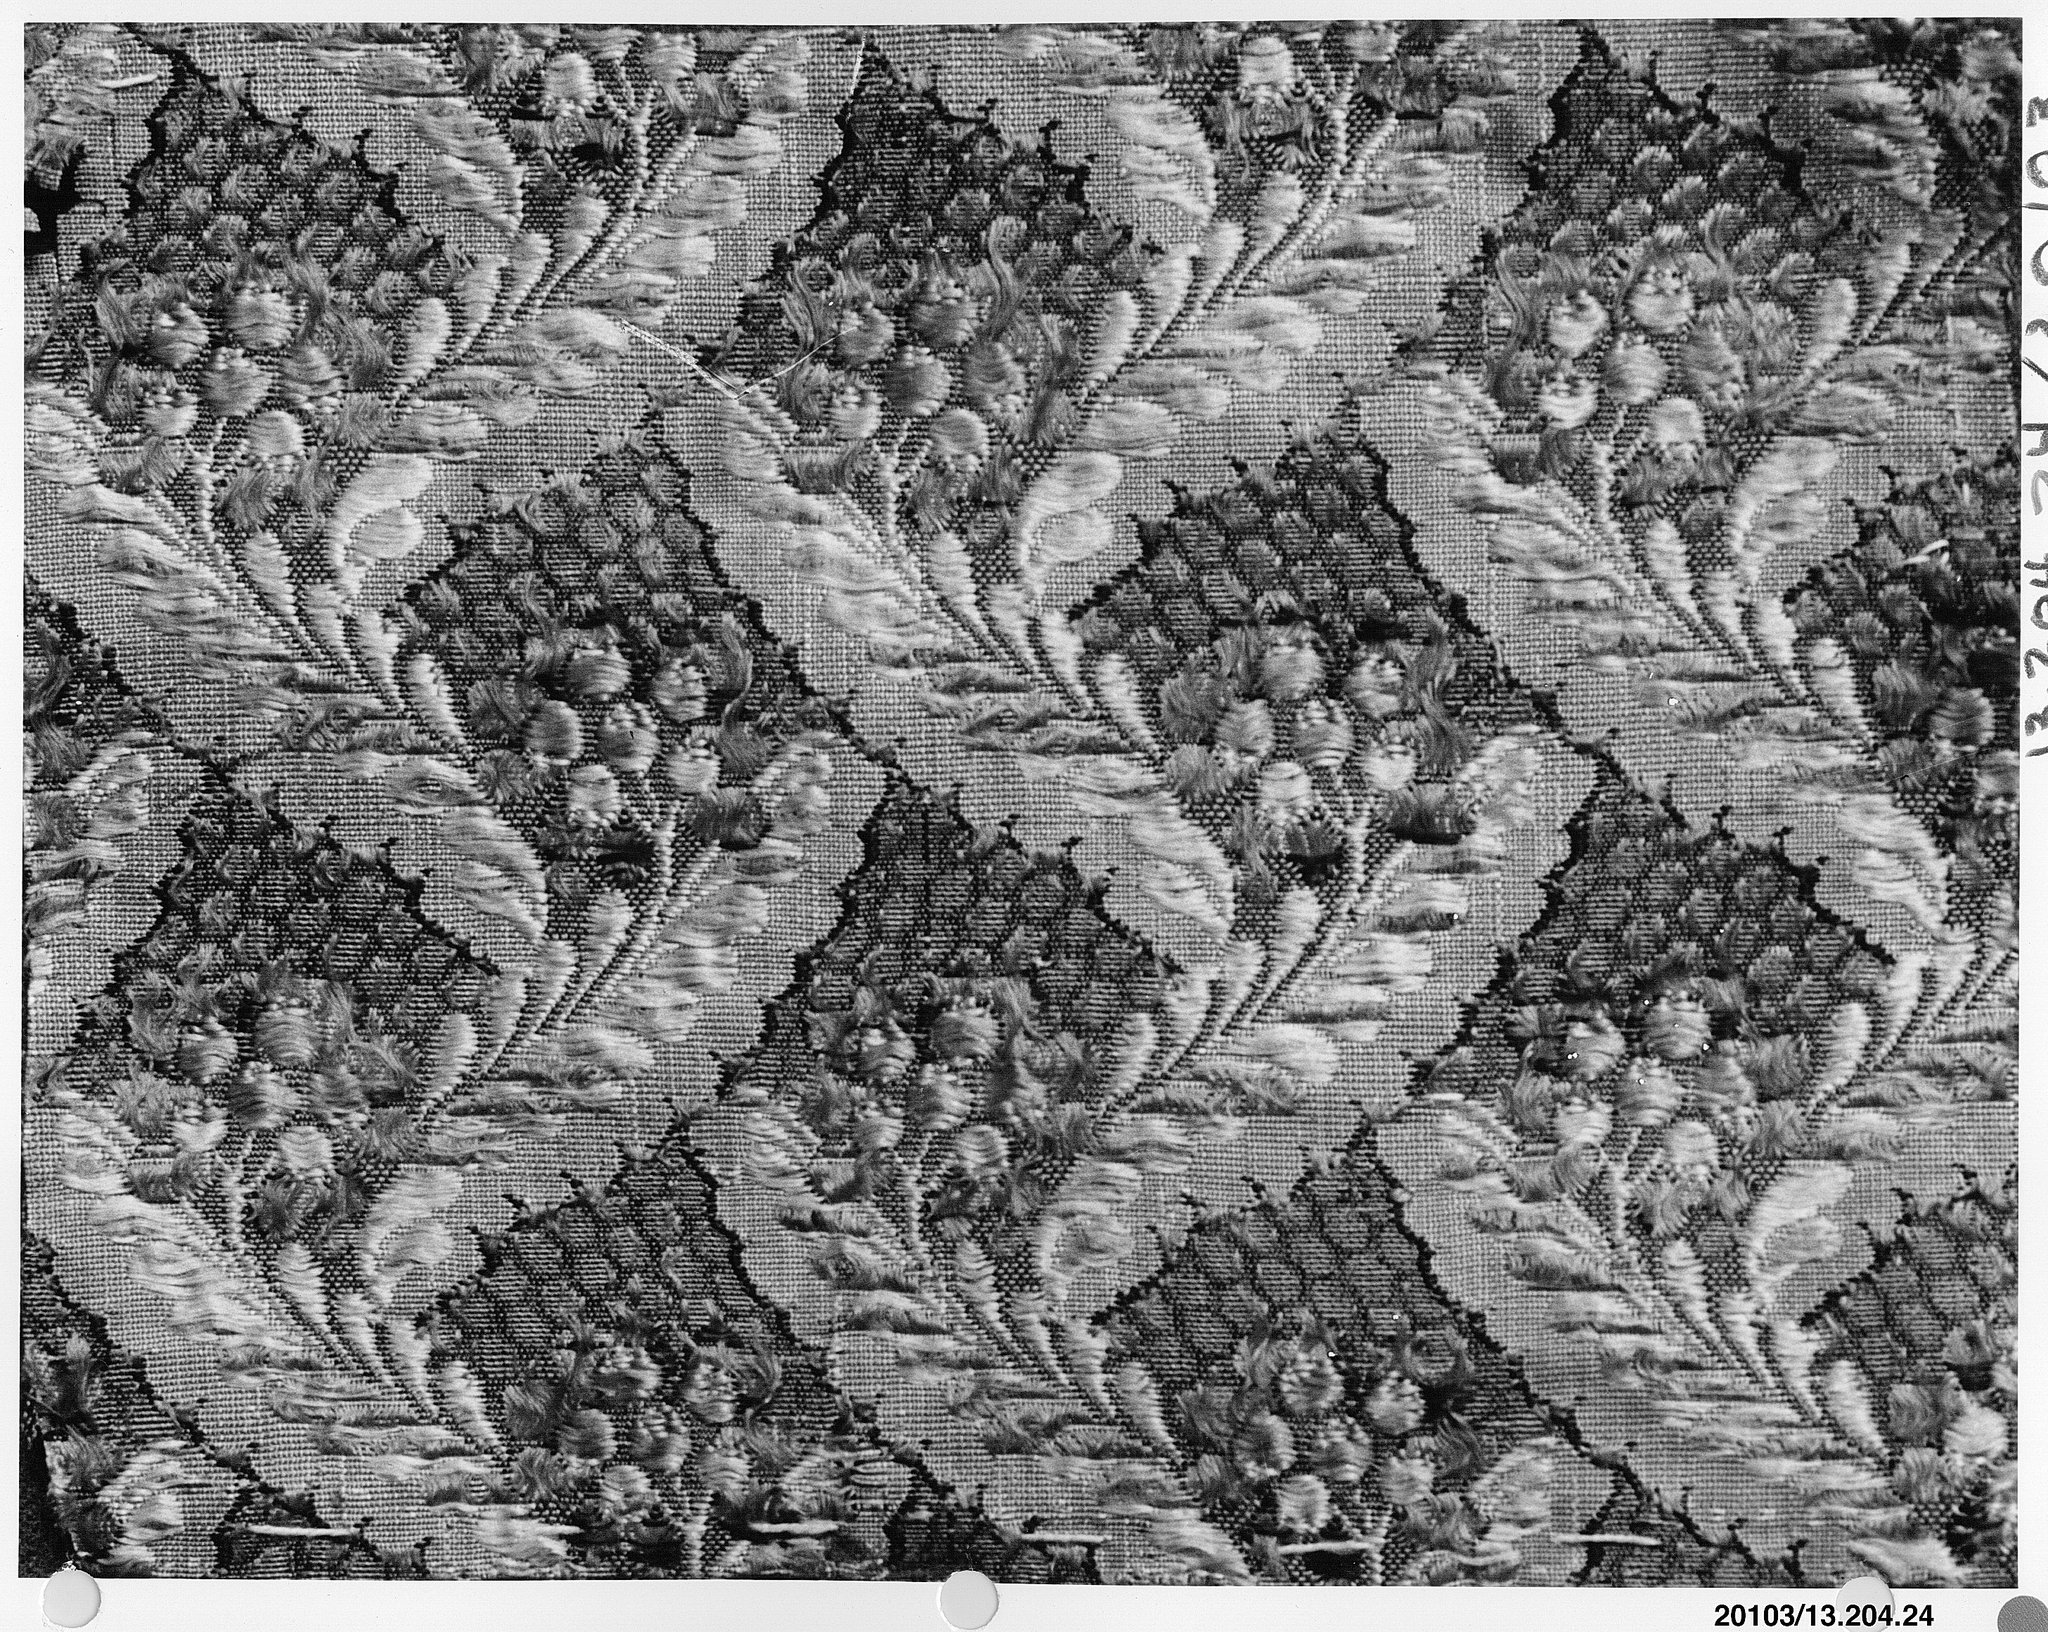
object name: piece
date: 1701-1750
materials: silk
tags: flowers,leaves